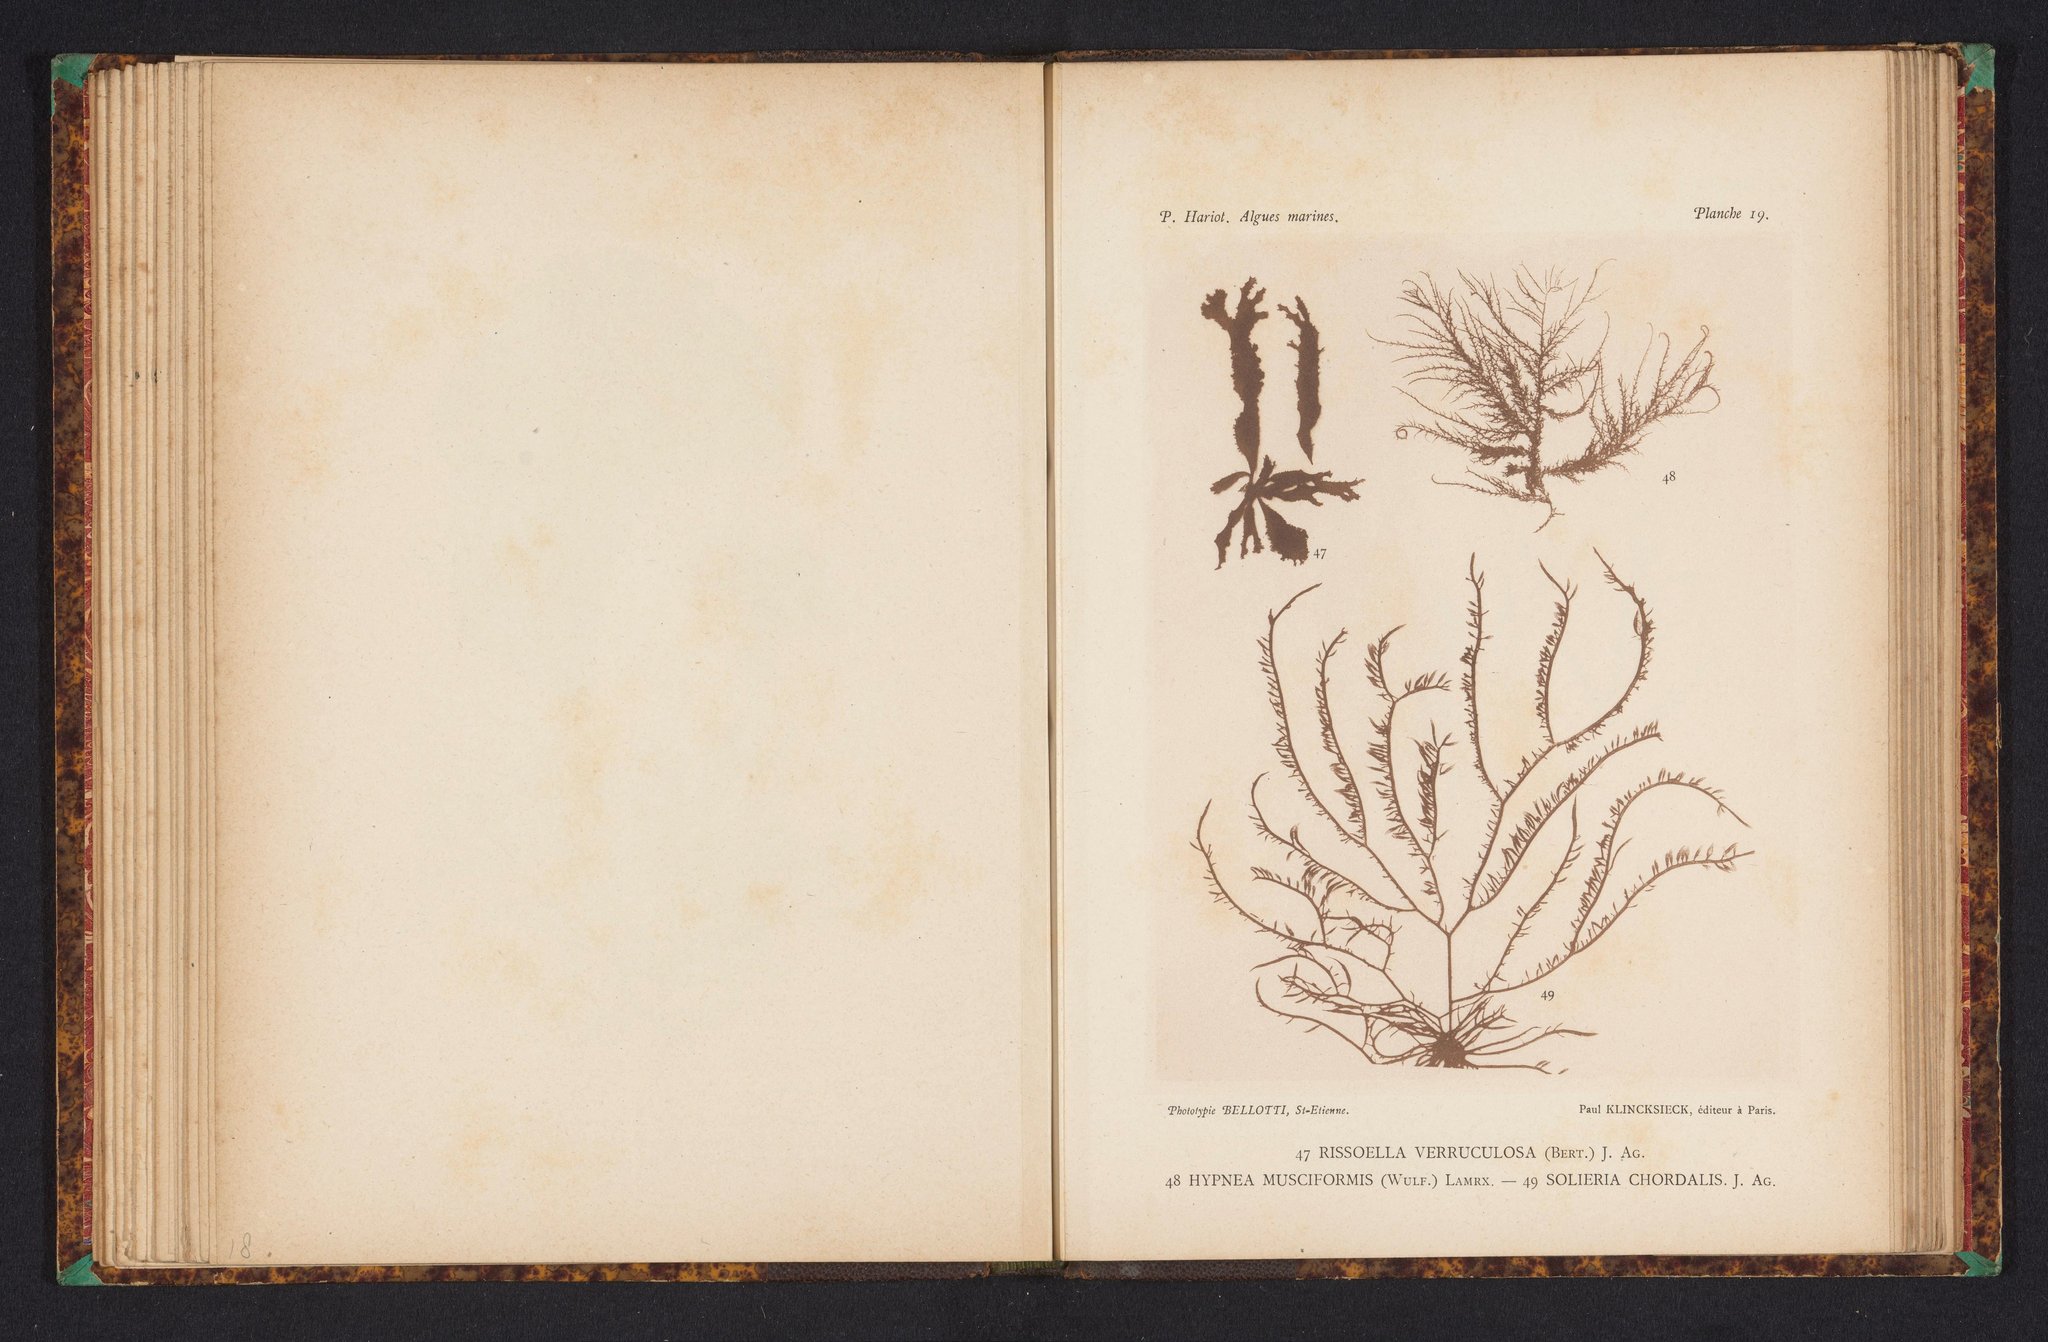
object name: photomechanical print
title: Drie soorten zeewier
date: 1882-1892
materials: paper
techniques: photograph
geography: france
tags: algae, seaweed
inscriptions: number: ‘47 (...) 49.’, number: ‘Planche 19.’, inscription: ‘Rissoella (...) chordalis. J. Ag.’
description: (47) is Rissoella verruculosa, (48) is Hypnea musciformis, (49) is Solieria chordalis.